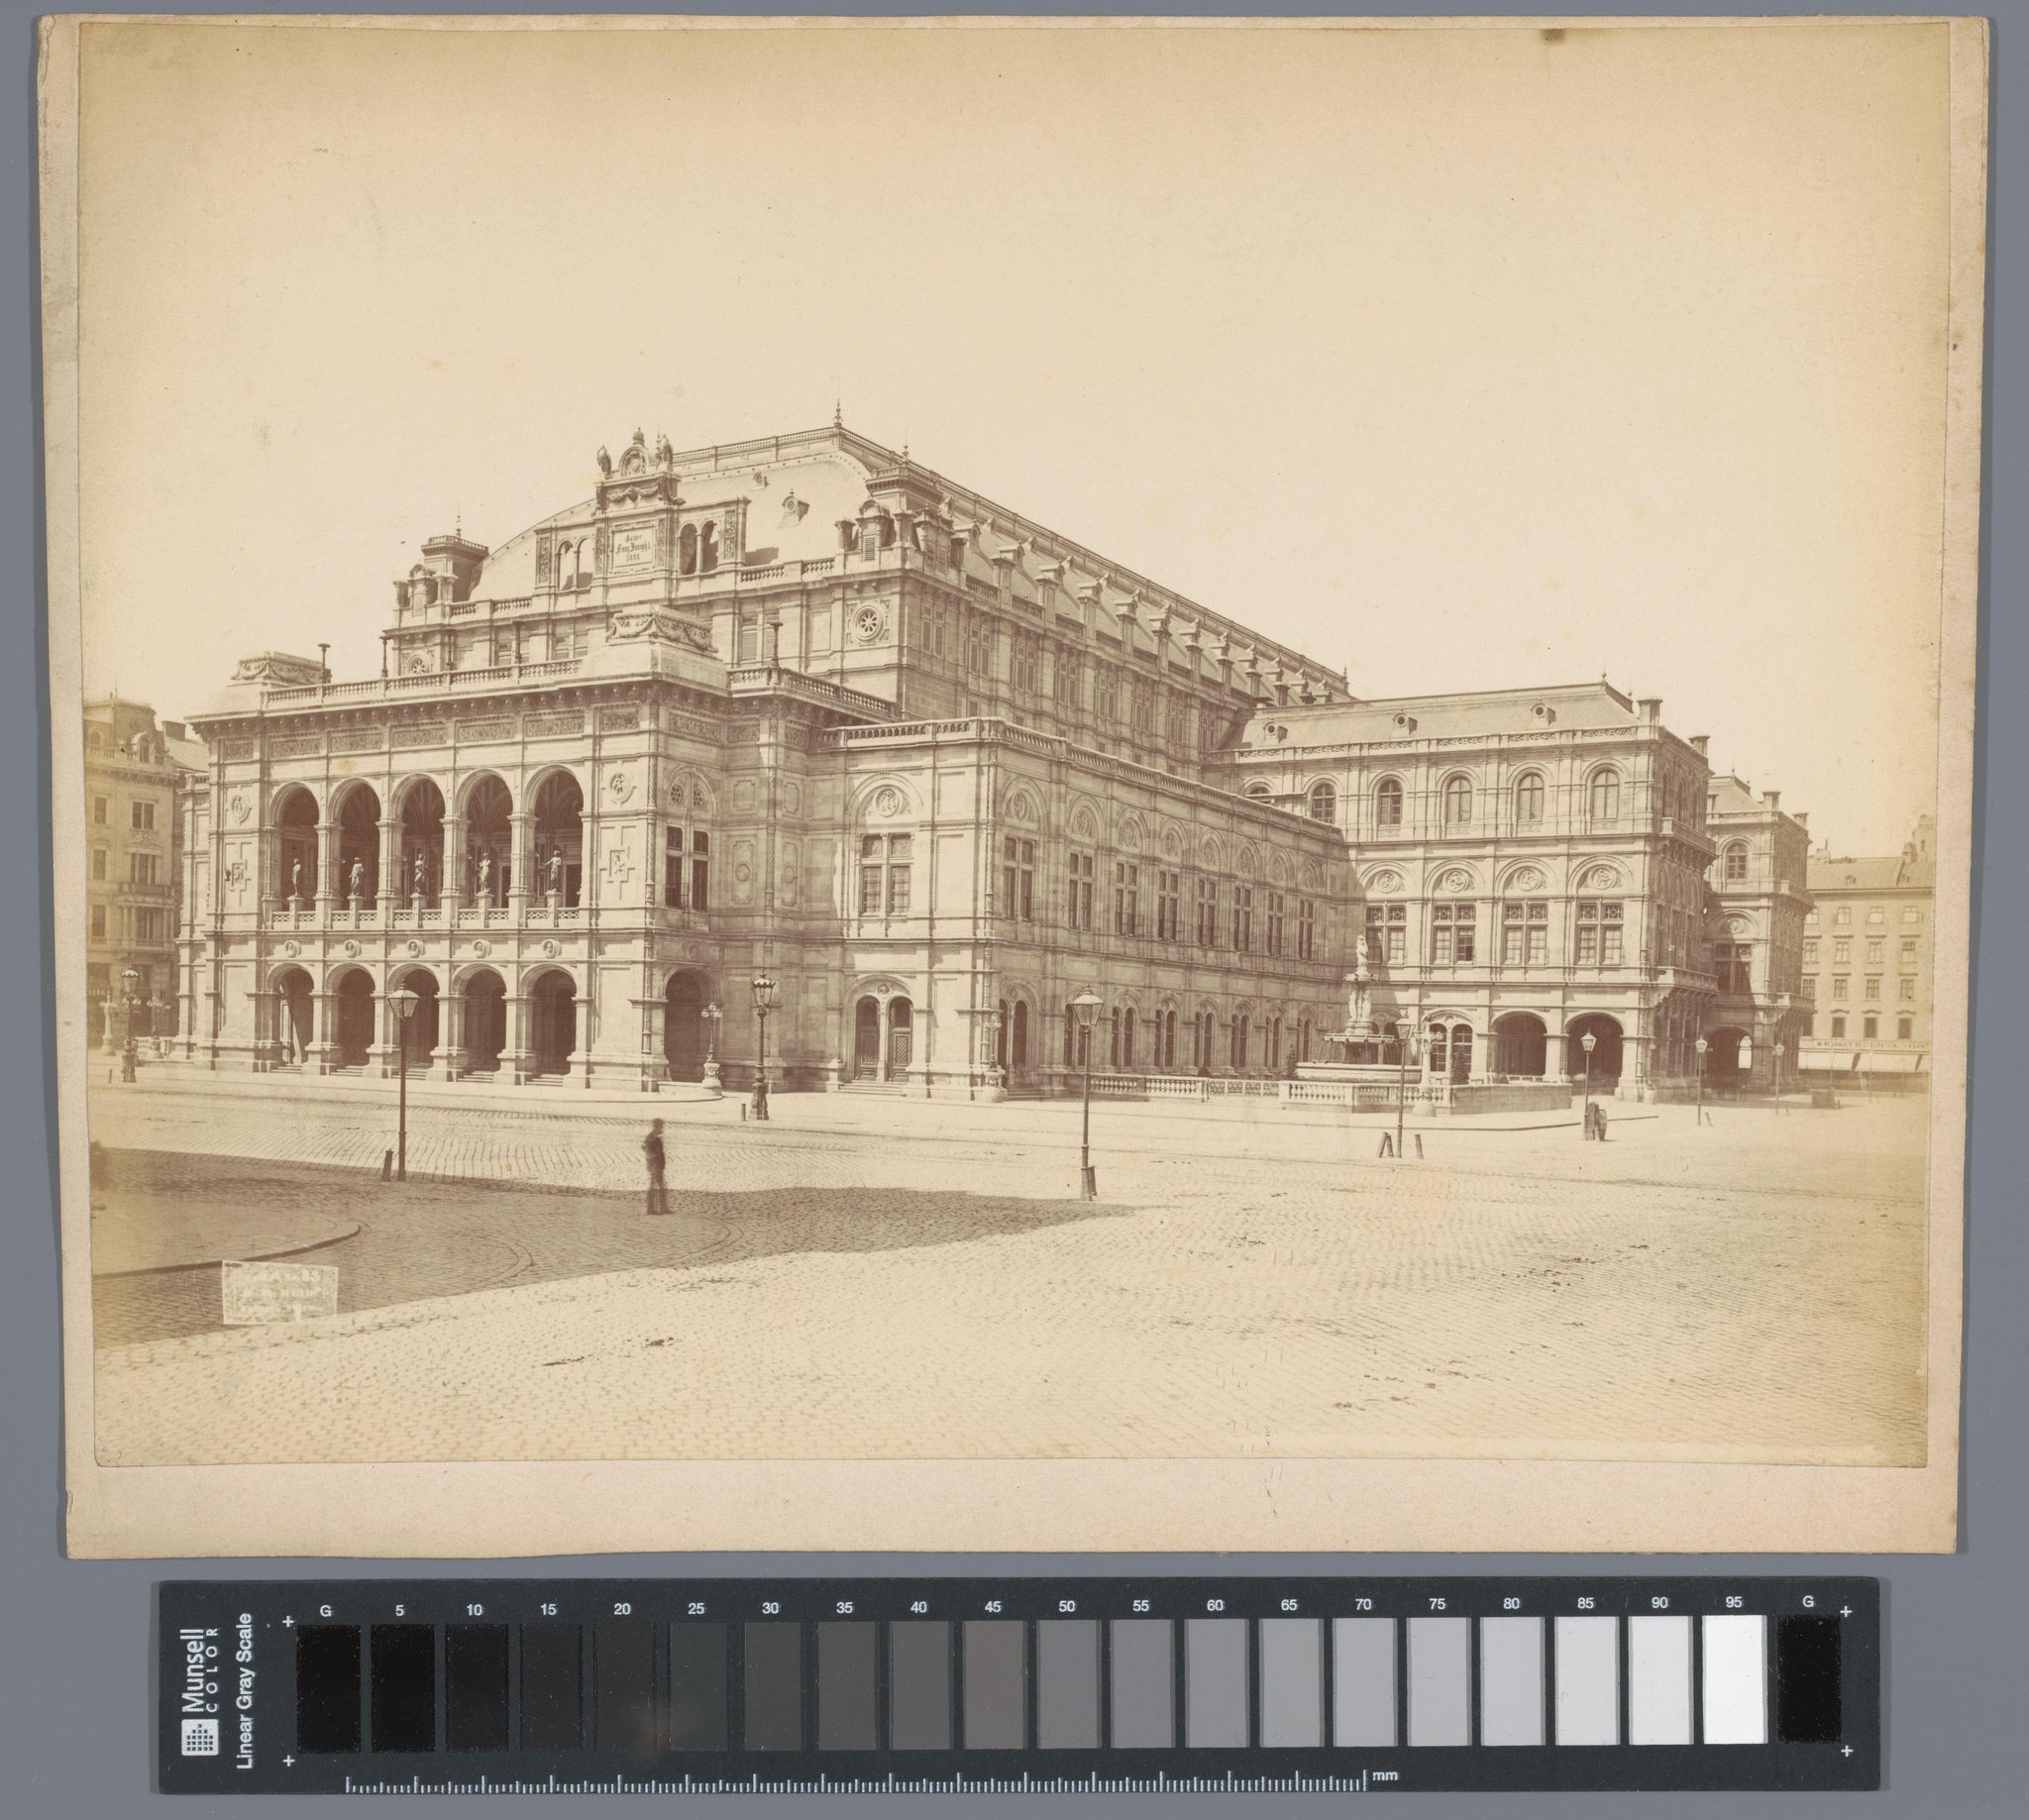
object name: photograph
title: Coll. A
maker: hermann heid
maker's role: fotograaf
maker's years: 1834-1891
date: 1869-1891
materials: cardboard, paper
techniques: albumen print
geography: vienna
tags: exterior ~ representation of a building, opera house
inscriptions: number: ‘Nr. 83’